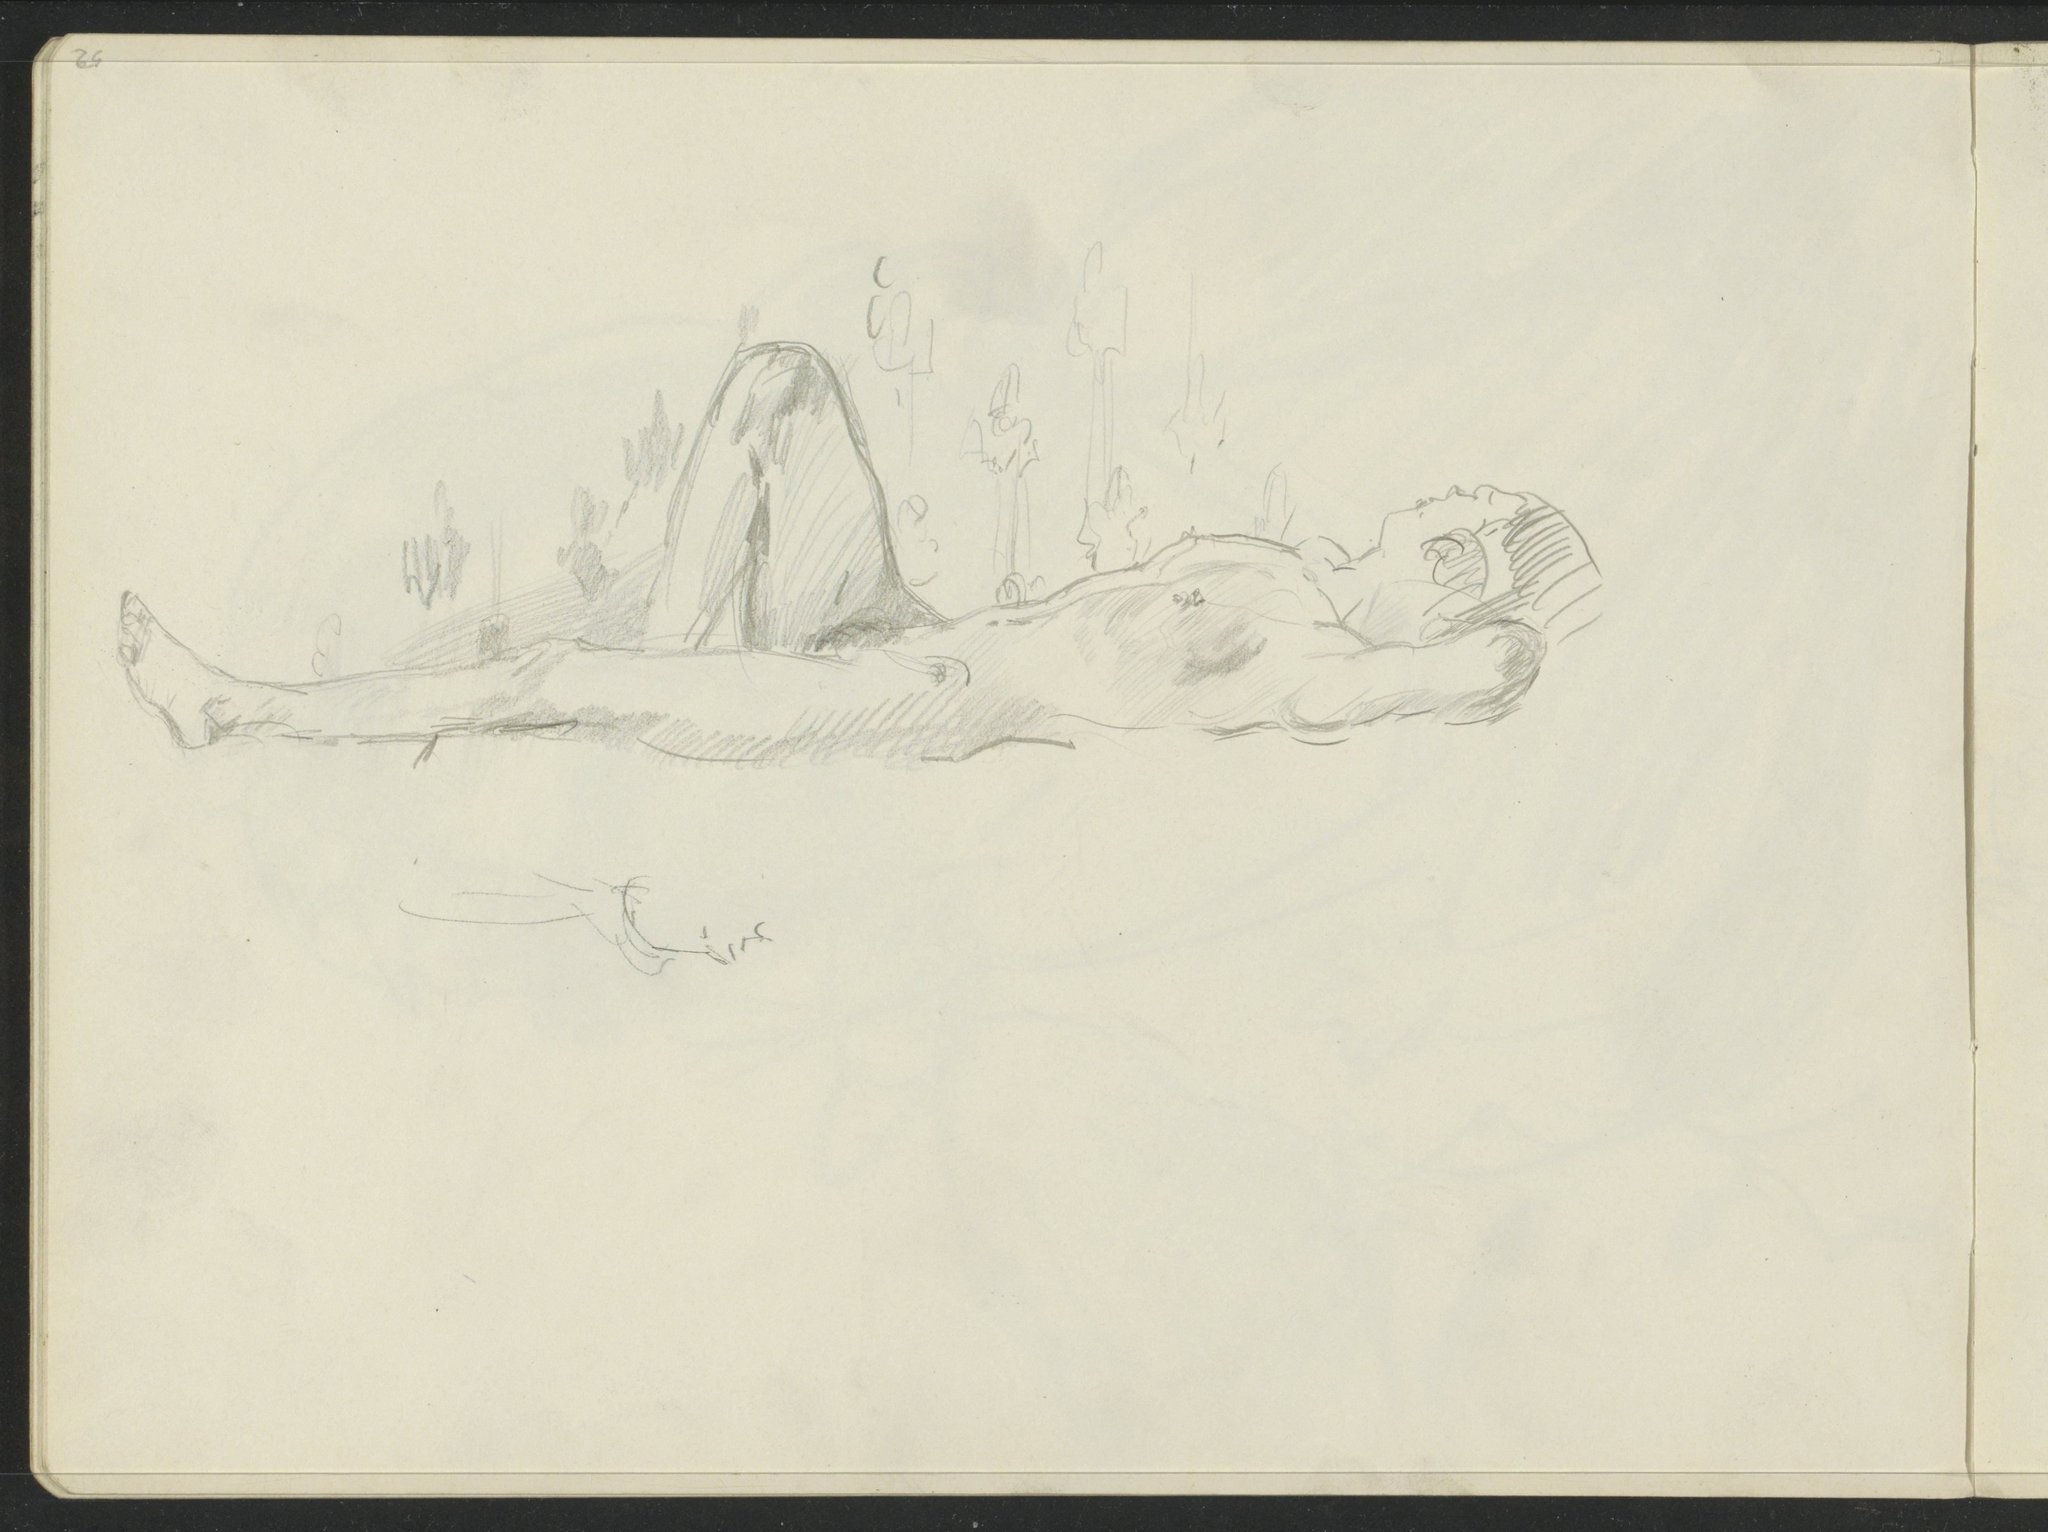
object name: sketchbook leaf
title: Reclining Female Nude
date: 1915-1934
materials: paper, pencil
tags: lying on the back with hands under the head - aa - female human figure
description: Met opgetrokken rechterbeen en haar armen onder haar hoofd. Blad 13 verso uit schetsboek XVI met 32 bladen.